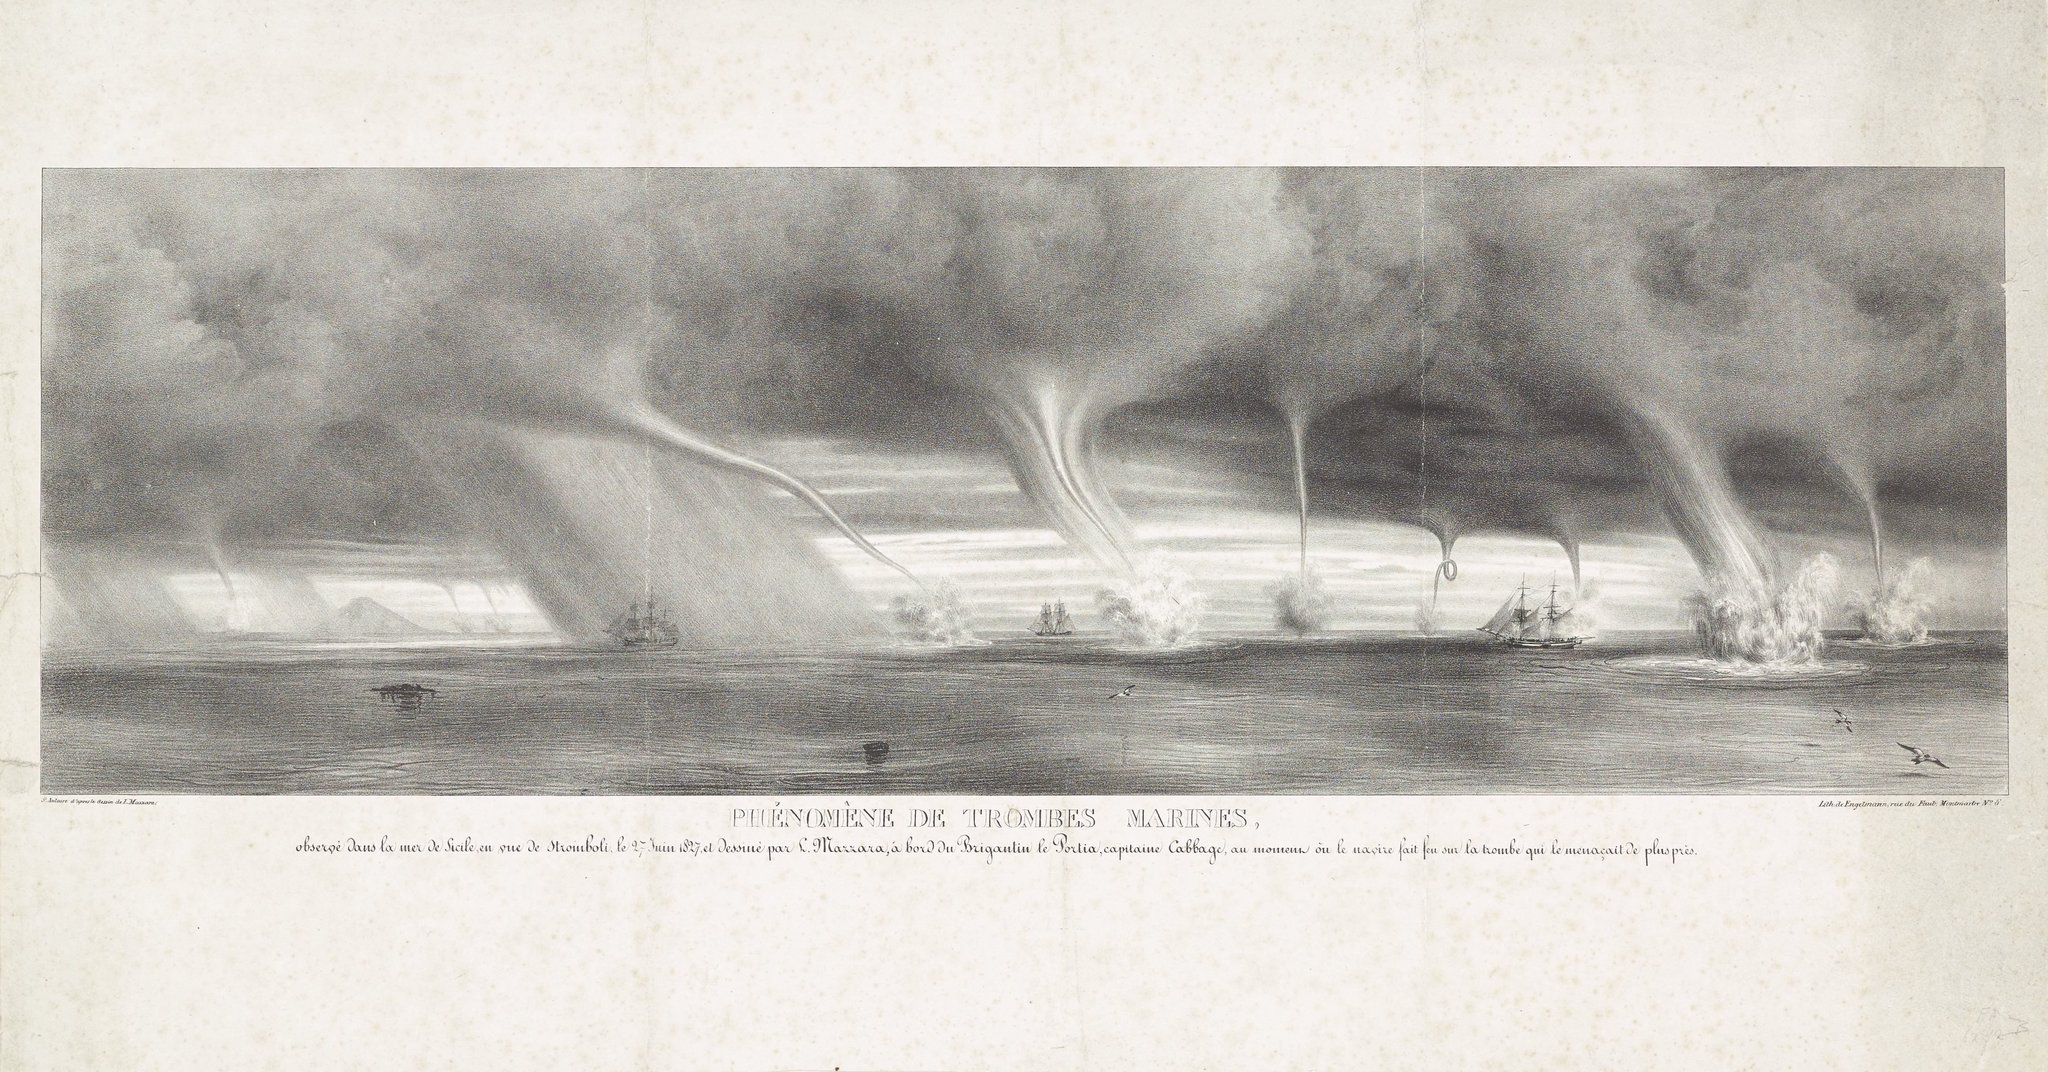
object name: print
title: Waterhozen op zee bij Sicilië, 1827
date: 1827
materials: paper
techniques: lithograph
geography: paris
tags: whirlwind, cyclone, hurricane, typhoon, tornado at sea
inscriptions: collector's mark: Lugt 2233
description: Meerdere waterhozen op zee, waargenomen bij het eiland Stromboli bij Sicilië op 27 juni 1827.